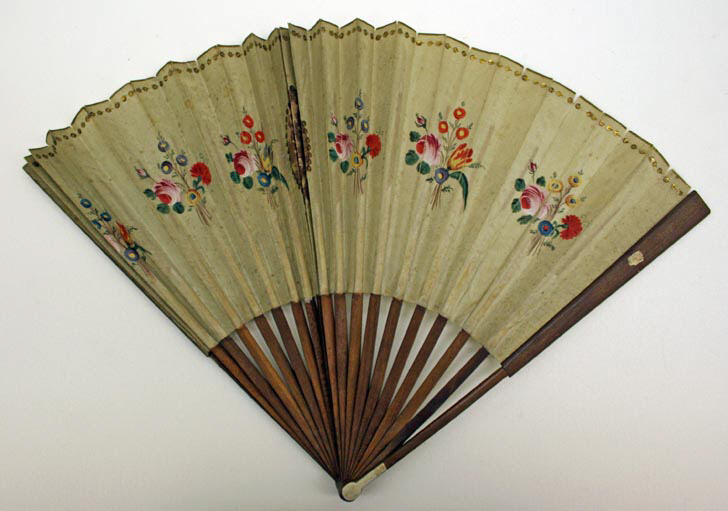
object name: fan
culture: european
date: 1800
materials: silk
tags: birds,men,women,flowers